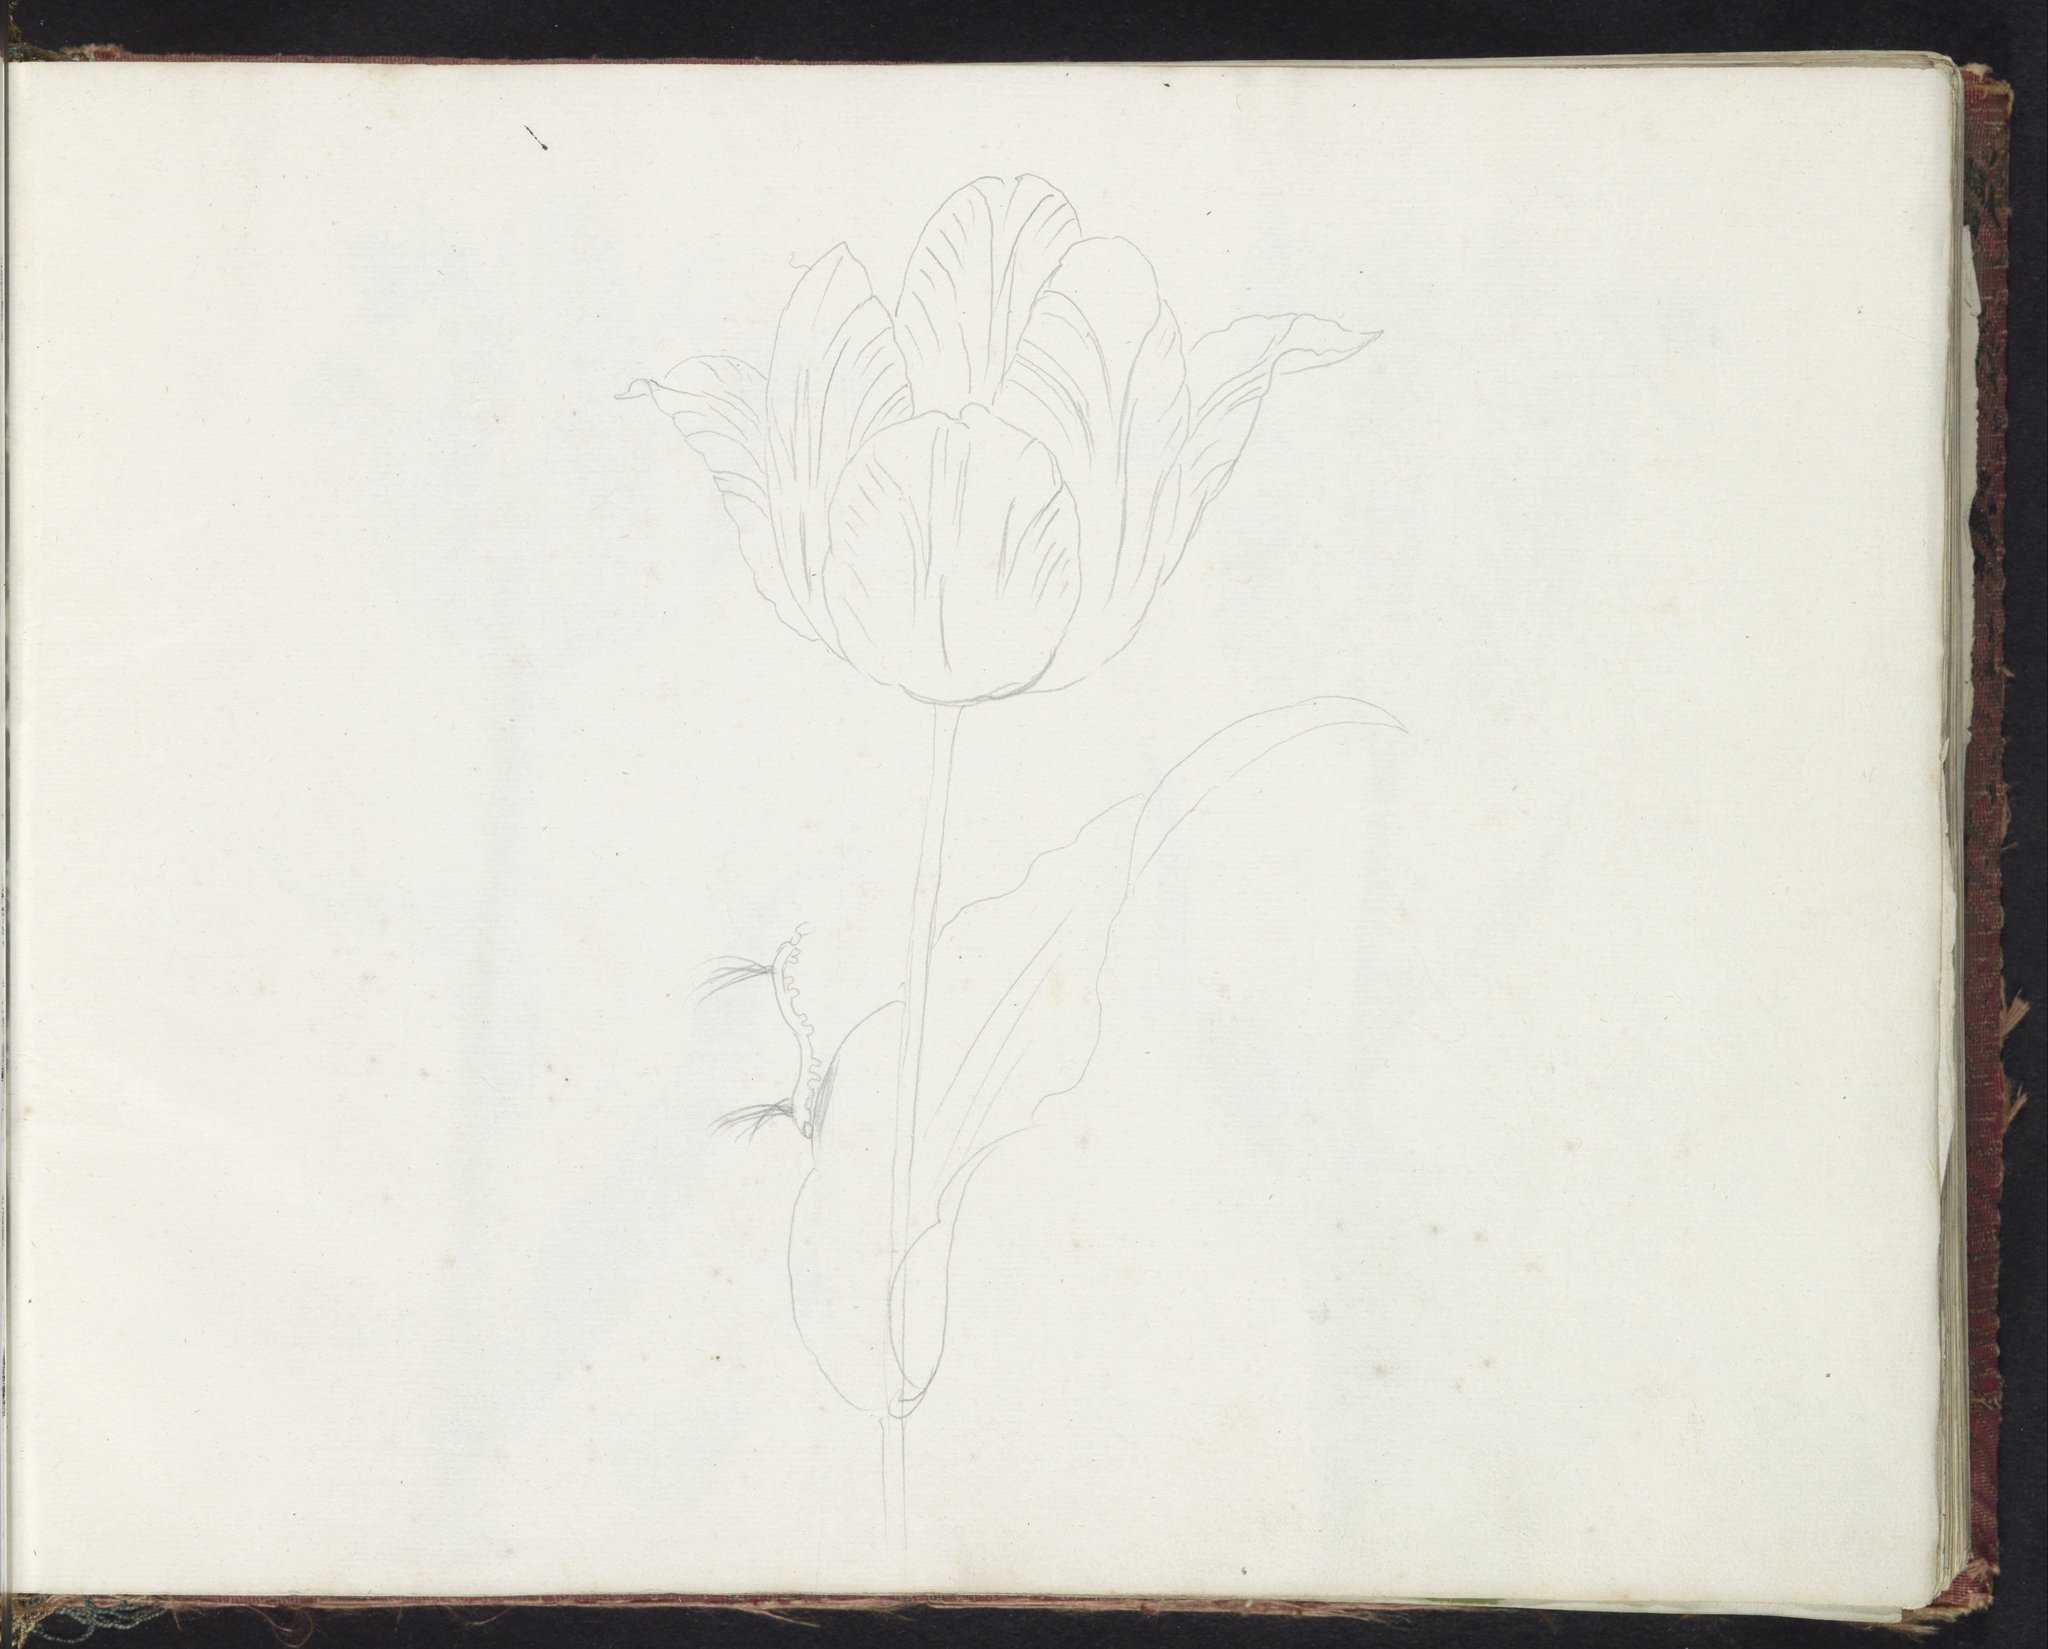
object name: drawing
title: Tulp met rups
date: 1637-1645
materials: paper, pencil, watercolor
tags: flowers: tulip, insects: caterpillar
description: De tekening maakt deel uit van een album.